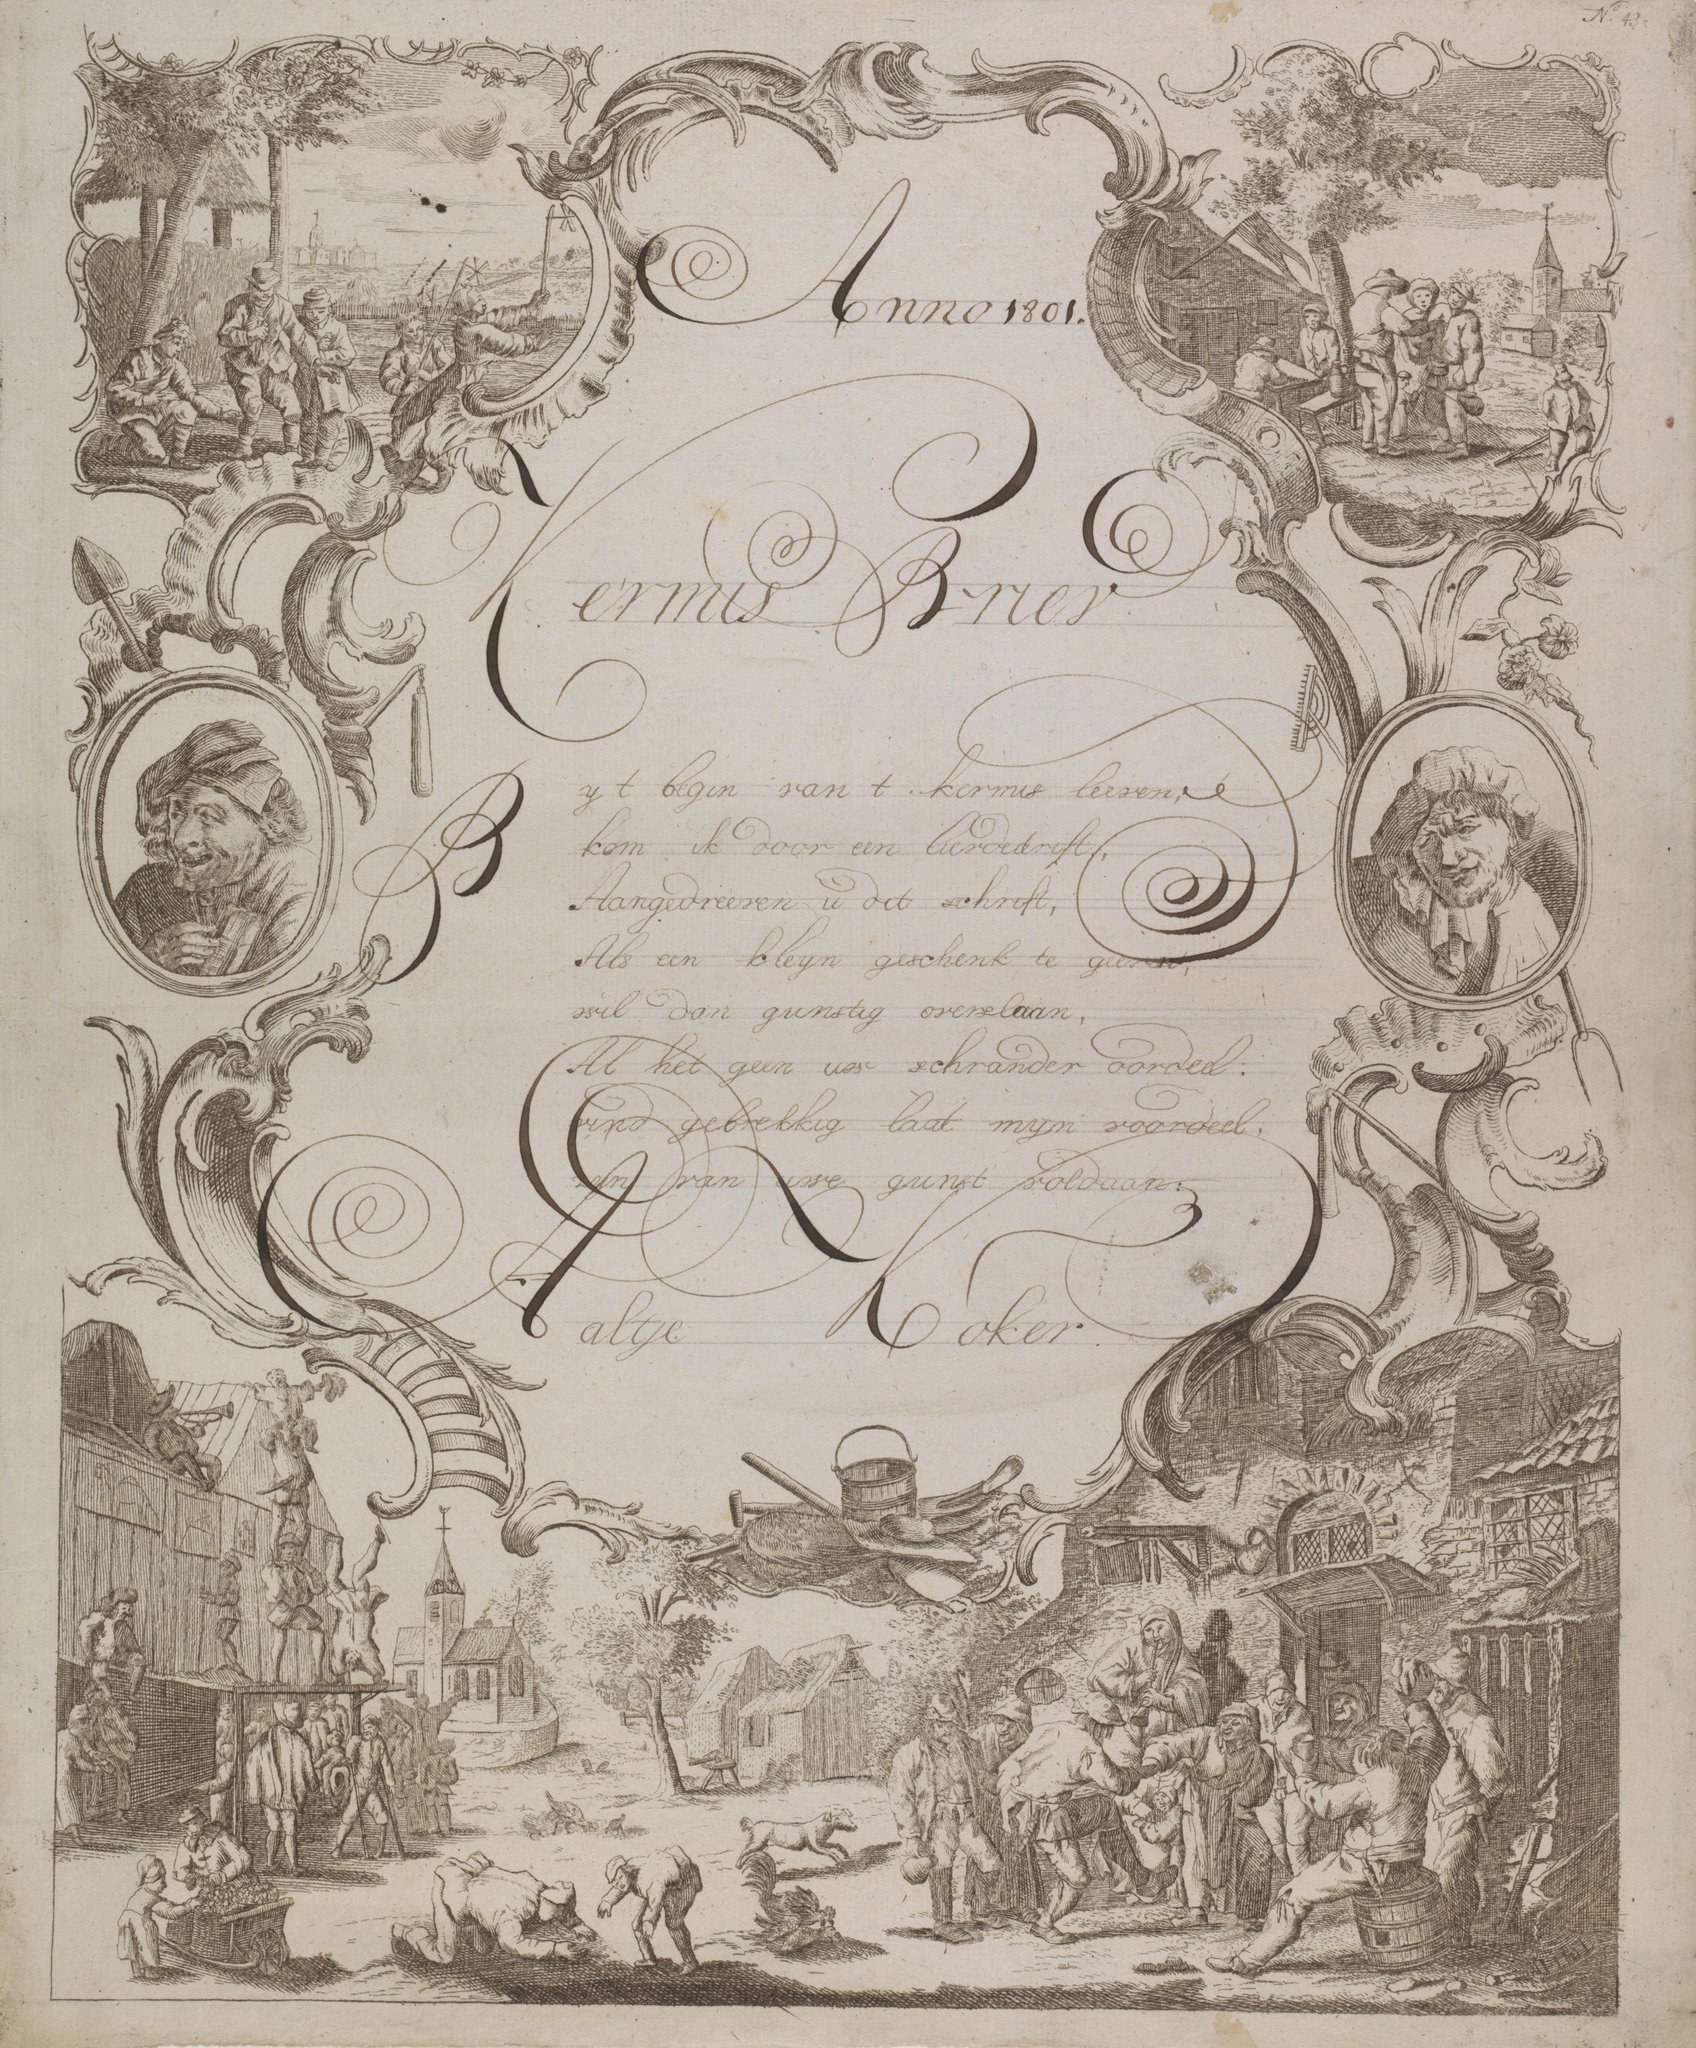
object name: wensbrief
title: Wensbrief met een herberg, drinkende boeren en acrobaten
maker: Anonymous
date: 1801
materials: ink, paper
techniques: calligraphy, etching, pen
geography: netherlands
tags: farmers, acrobat ~ circus, the show; fair and circus performers, alcoholic drinks, drinking, hotel, hostelry, inn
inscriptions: collector's mark: Lugt 2760, inscription: ‘Kermis briev / Bijt begin van t kermis leeven ...’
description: Wensbrief met beschreven cartouche binnen een decoratief kader met voorstellingen van een herberg, drinkende boeren en acrobaten. Handgeschreven bericht in kalligrafie (kermisbrief) door Aaltje Koker. Genummerd rechtsboven: No. 43.